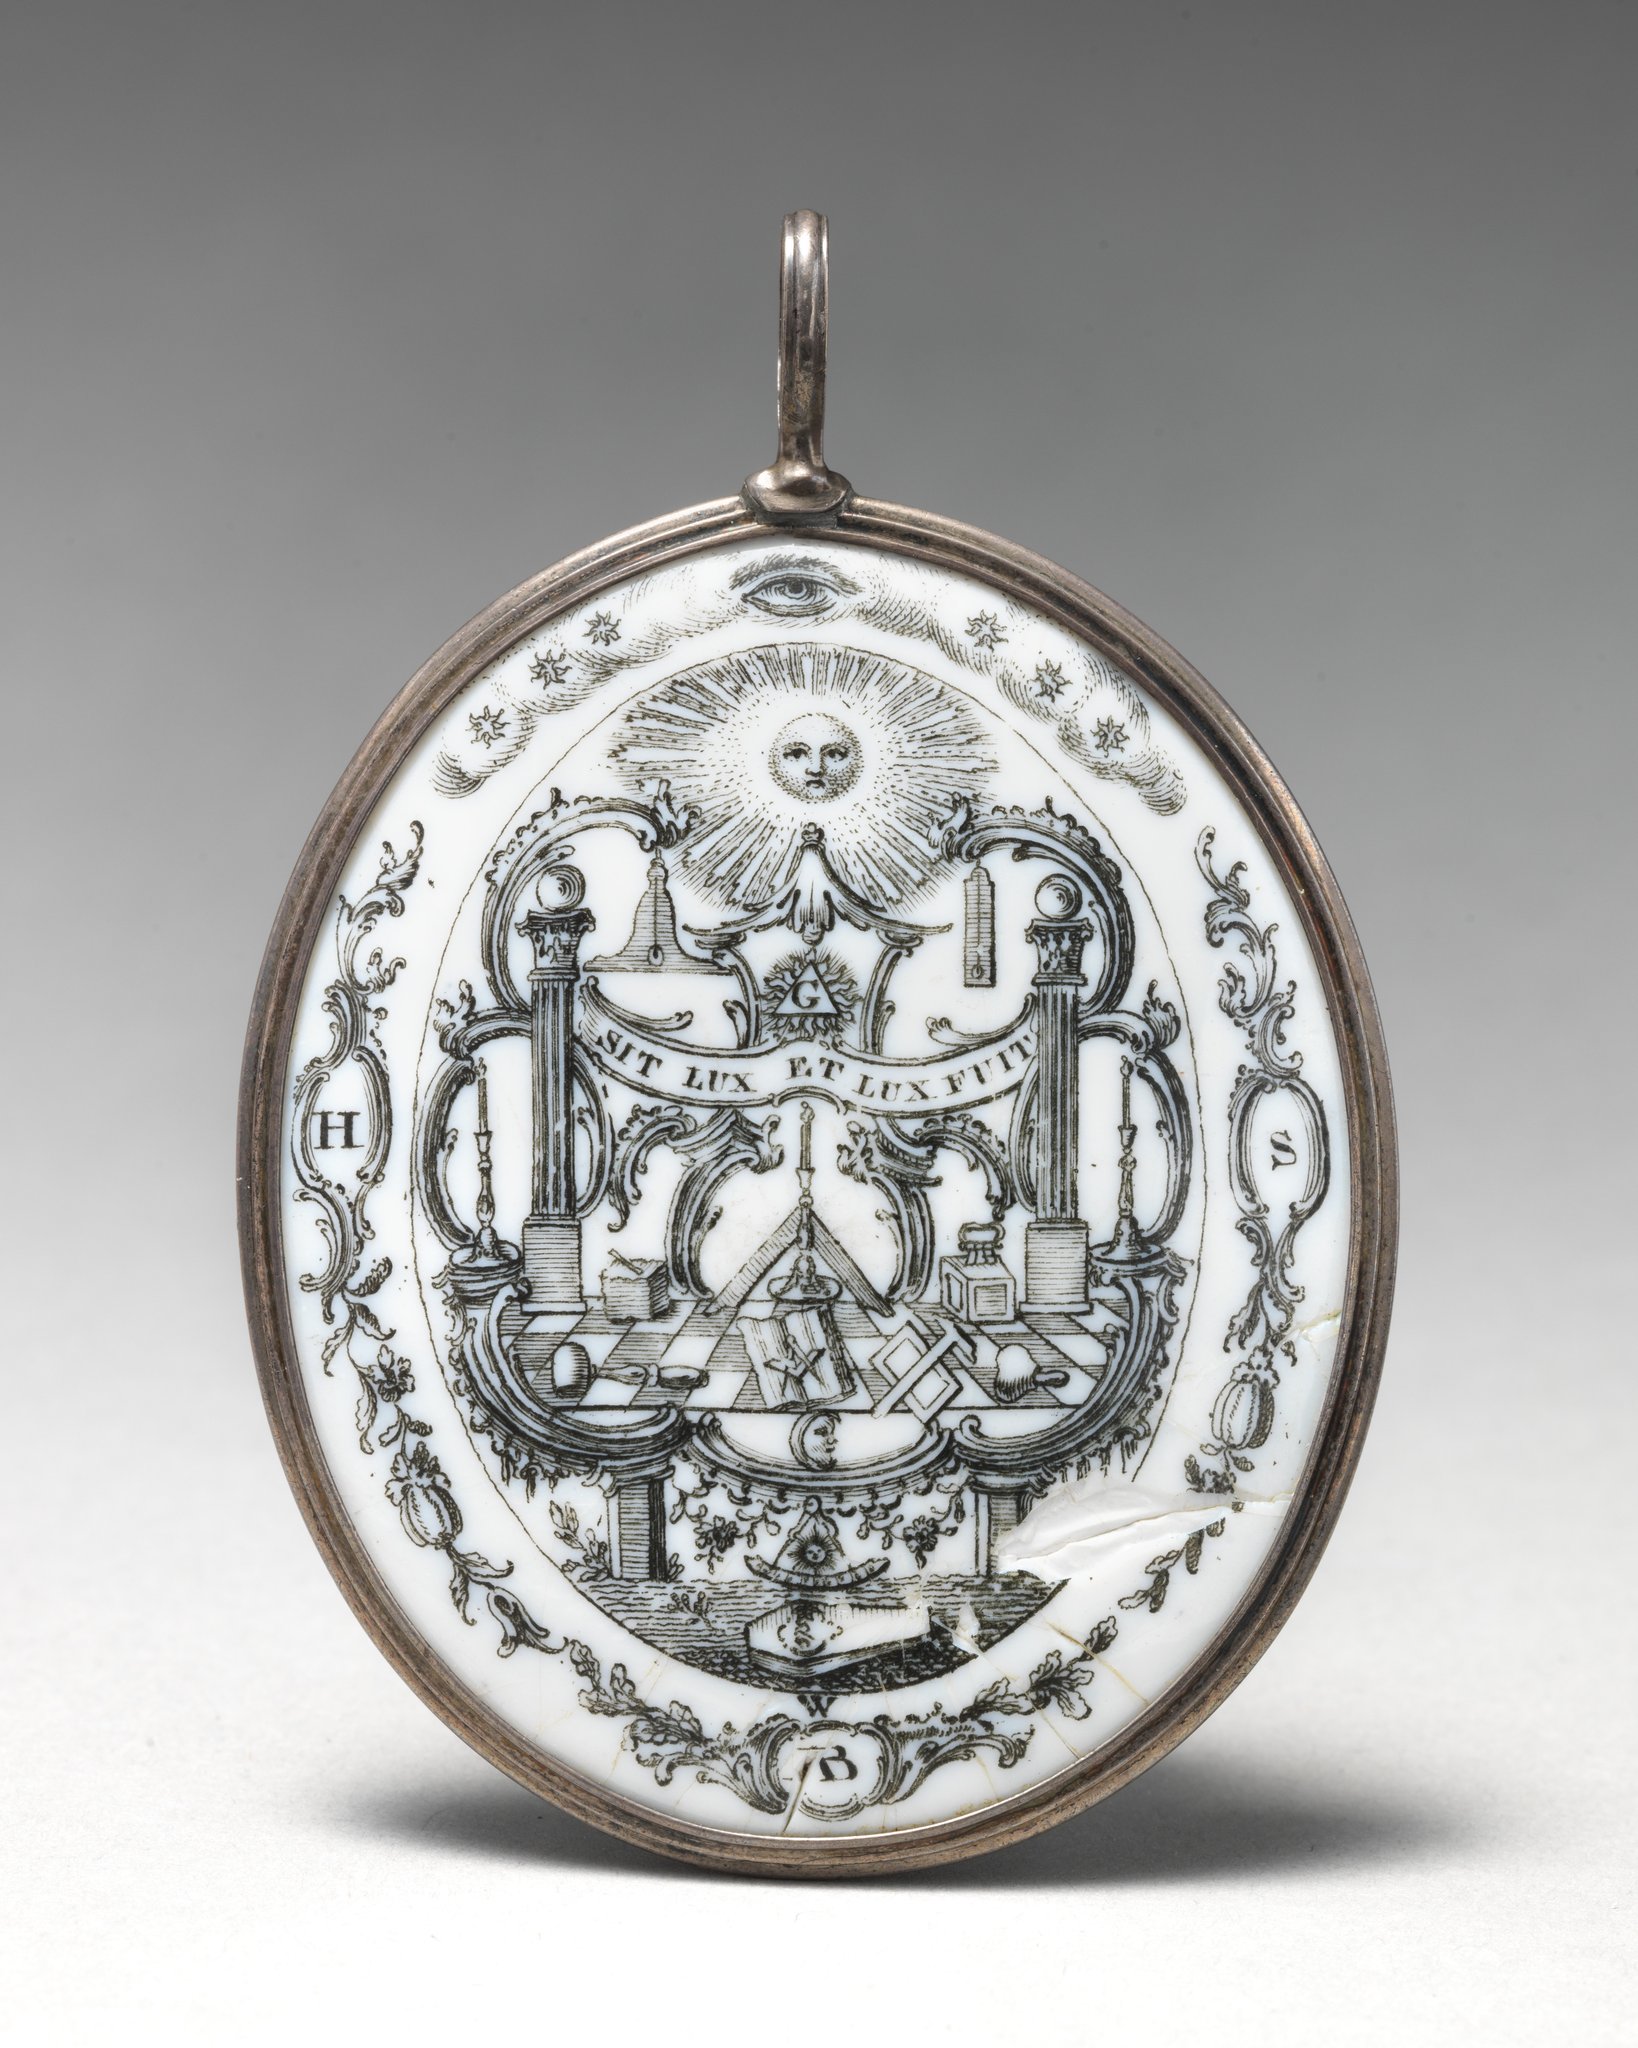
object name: pendant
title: Pendant with Masonic symbols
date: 1758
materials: copper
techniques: enamel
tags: coat of arms